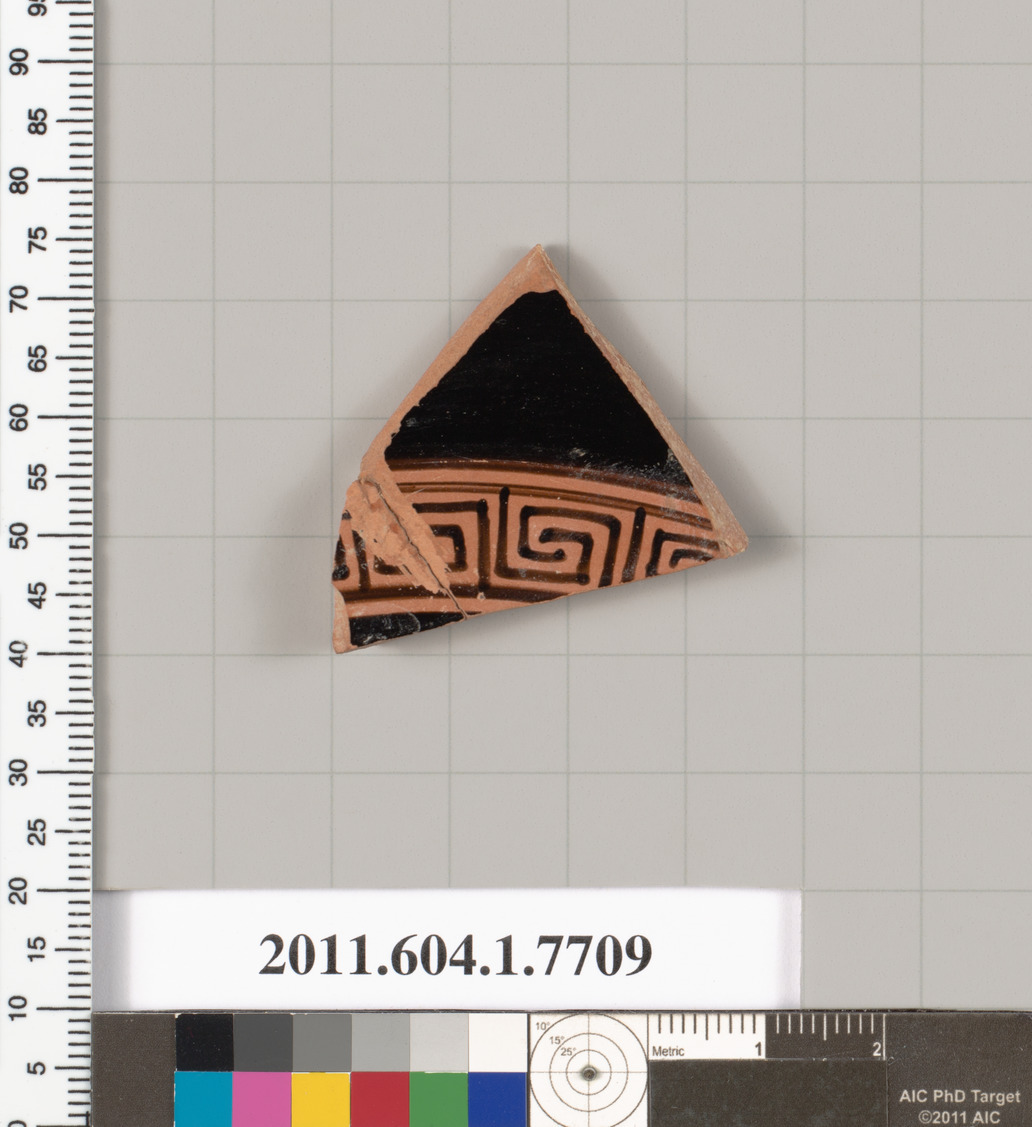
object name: kylix fragment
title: Terracotta fragment of a kylix (drinking cup)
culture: greek, attic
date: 460-450 BCE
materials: terracotta